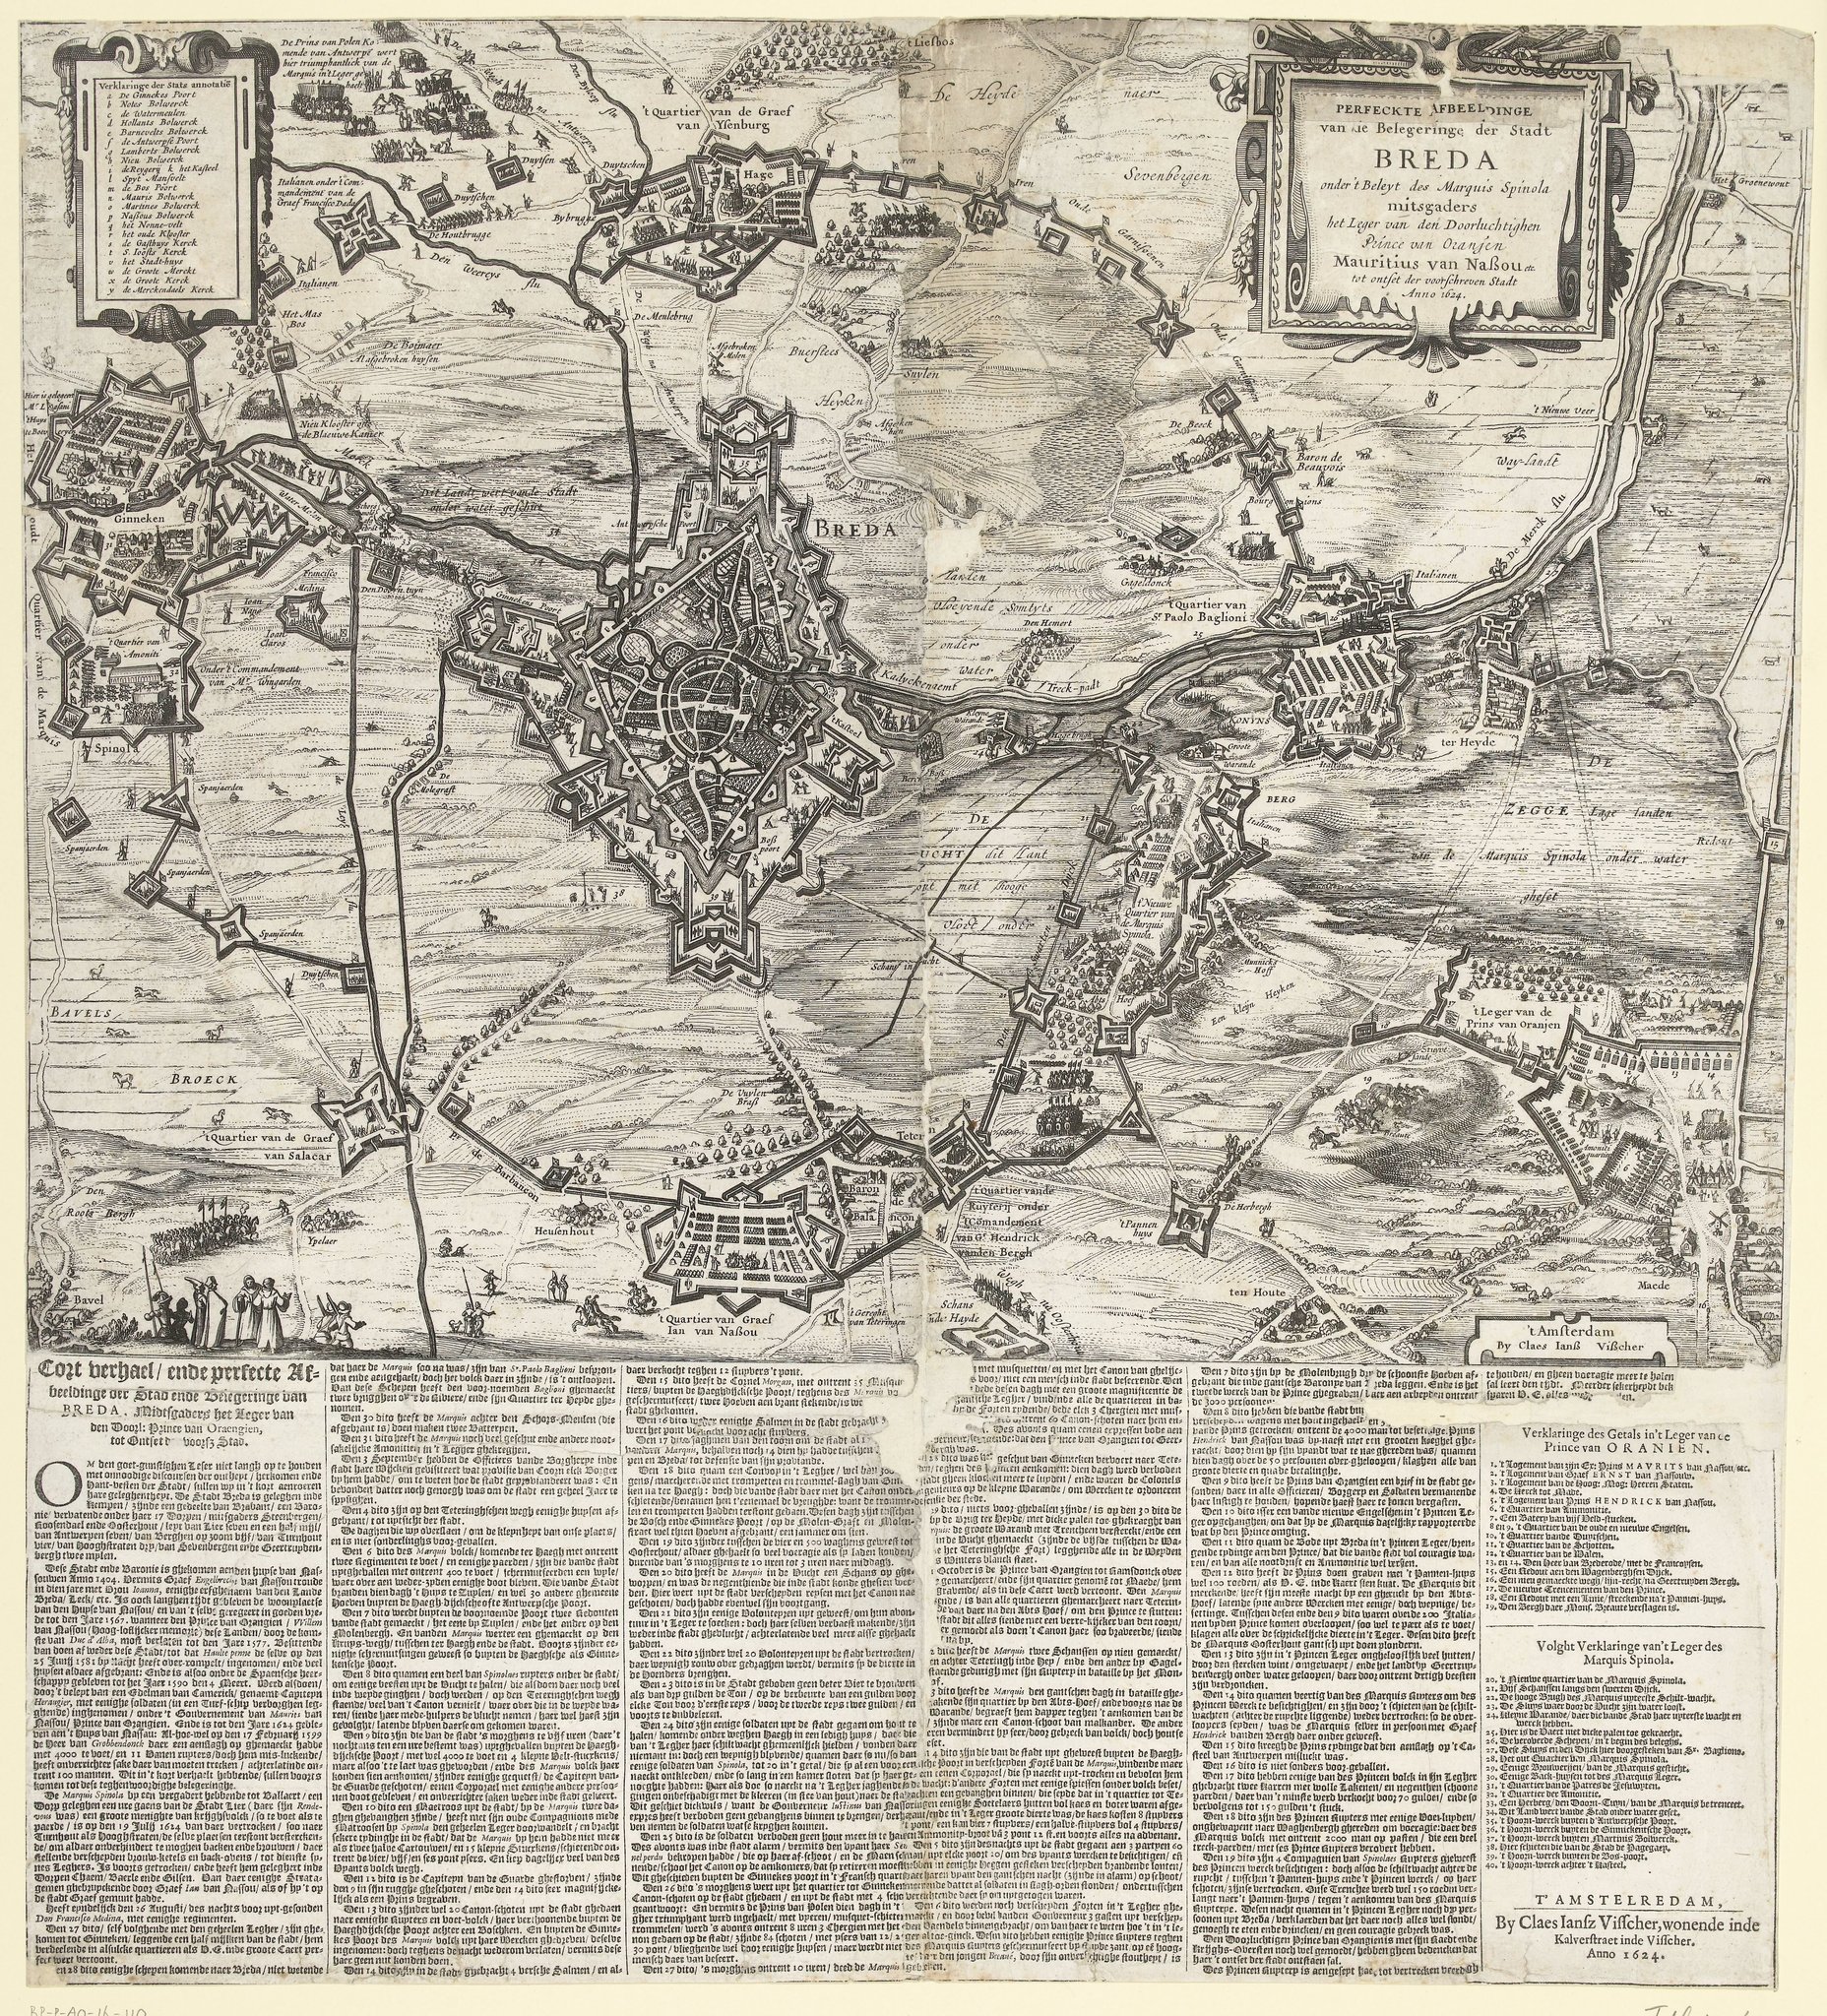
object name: map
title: Perfeckte Afbeeldinge van de Belegeringe der Stadt Breda onder 't Beleyt des Marquis Spinola mitsgaders het Leger van den Doorluchtighen Prince van Oranjen Mauritius van Nassou etc. tot ontset der voorschreven Stadt Anno 1624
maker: claes jansz. visscher (ii)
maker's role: draughtsman, print maker, publisher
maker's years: 1586-1652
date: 1624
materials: paper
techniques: etching, letterpress printing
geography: amsterdam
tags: the hague, maurice (prince of orange), maps of separate countries or regions, siege, position war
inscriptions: inscription: ‘Veldslagen 734’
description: Het beleg van Breda door het Spaanse leger onder Spinola, 27 augustus 1624 tot 5 juni 1625. Grote kaart met een plan van de stad en omliggende land met de omsingeling van de stad door het Spaanse leger. Rechtsboven een vierkante cartouche met de titel (bovenste deel overplakt met een stuk papier), linksboven de legenda a-y. Rechtsonder het kamp van het Staatse leger onder Maurits dat ter ontzet is gekomen. Vastgeplakt onder de prent twee bladen met tekst in het Nederlands.